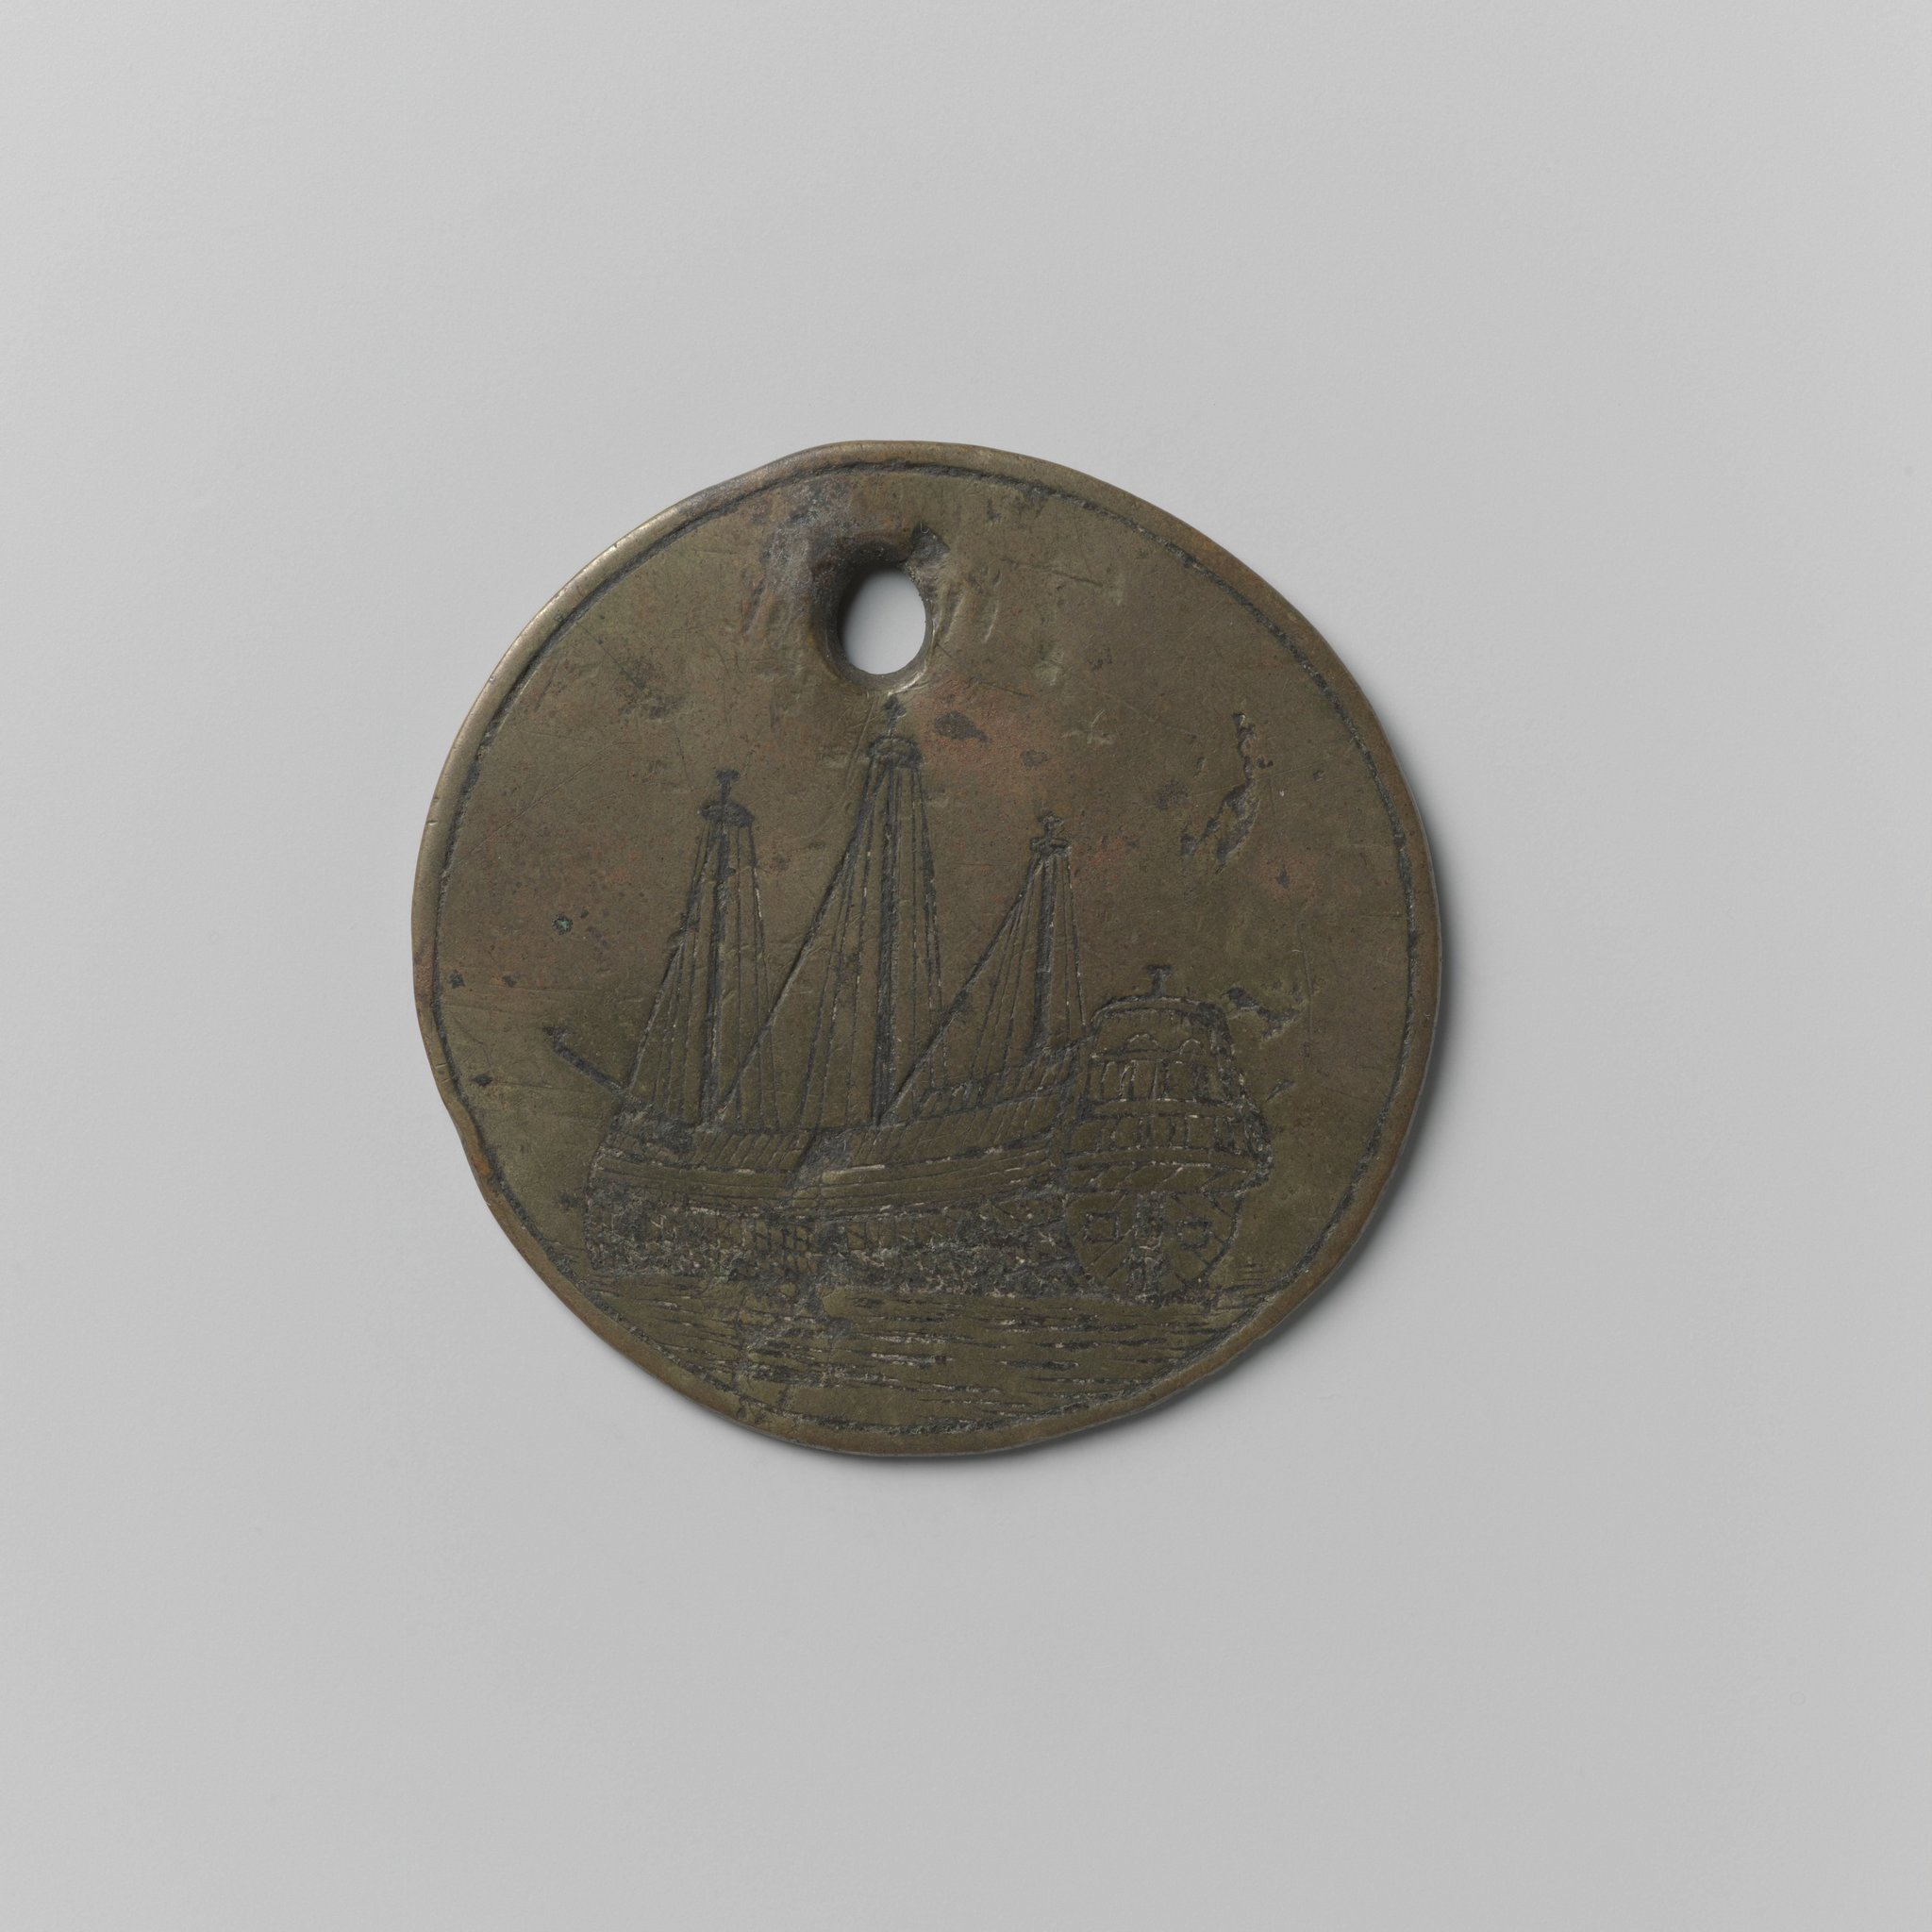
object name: medal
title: Scheepstimmerliedengilde van Amsterdam, gildepenning van Joonis Tuenisz de Vrij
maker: Anonymous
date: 1723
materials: brass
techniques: engraving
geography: amsterdam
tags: amsterdam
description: Messing penning met gat erin. Voorzijde: nog niet opgetuigde driemaster te water. Keerzijde: opschrift.